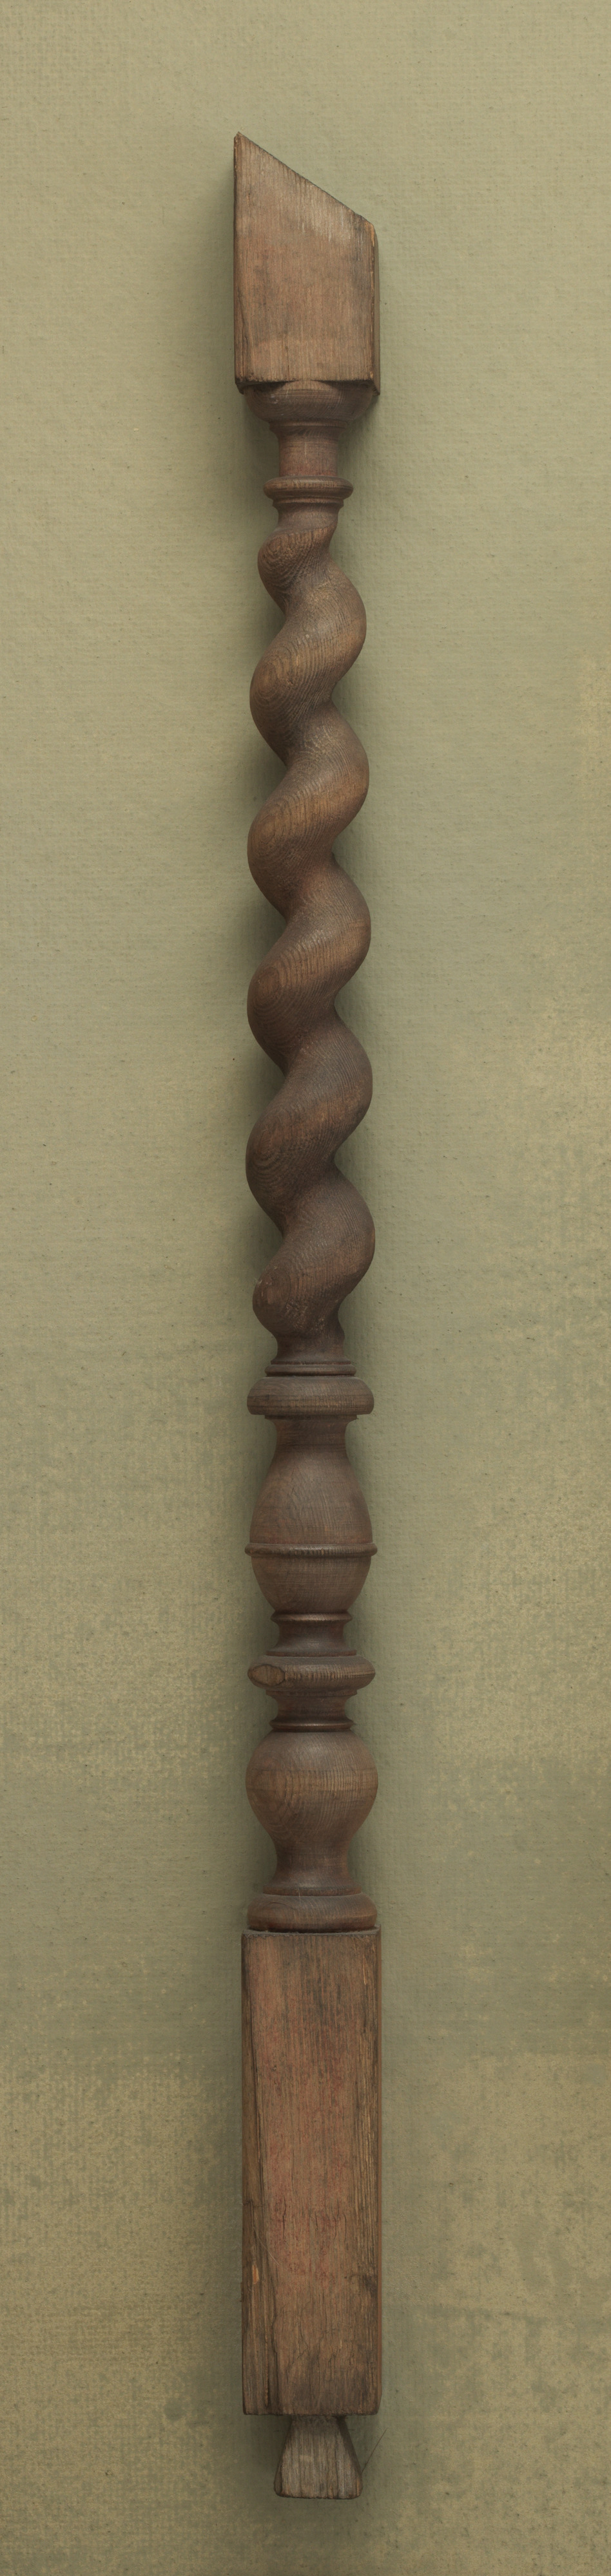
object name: baluster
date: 1701-1750